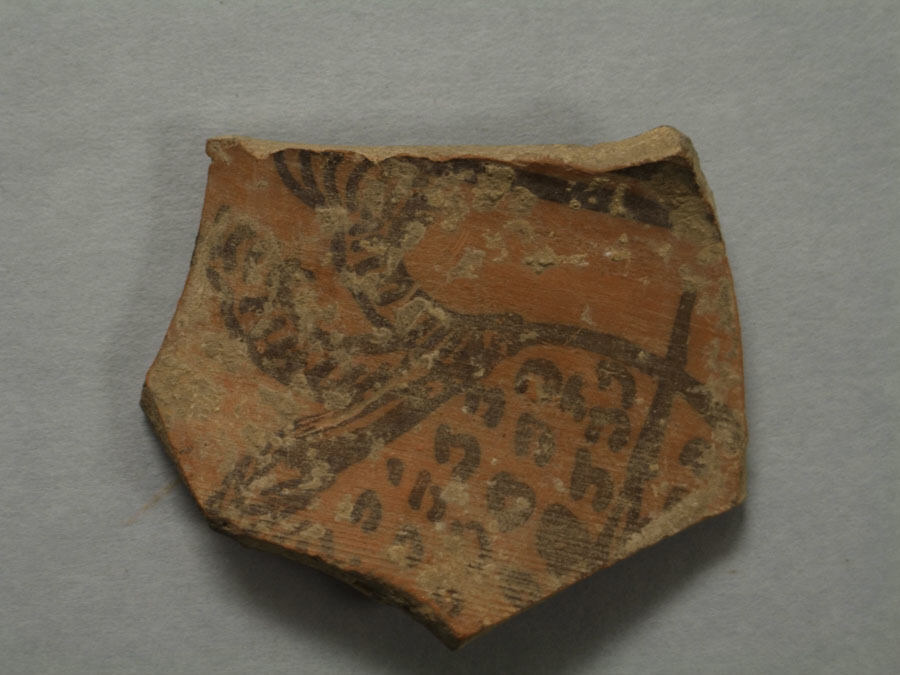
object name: shard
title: Shard: Forepaws of Spotted Carnivore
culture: pakistani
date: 301-500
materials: terracotta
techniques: painting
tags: gandhara